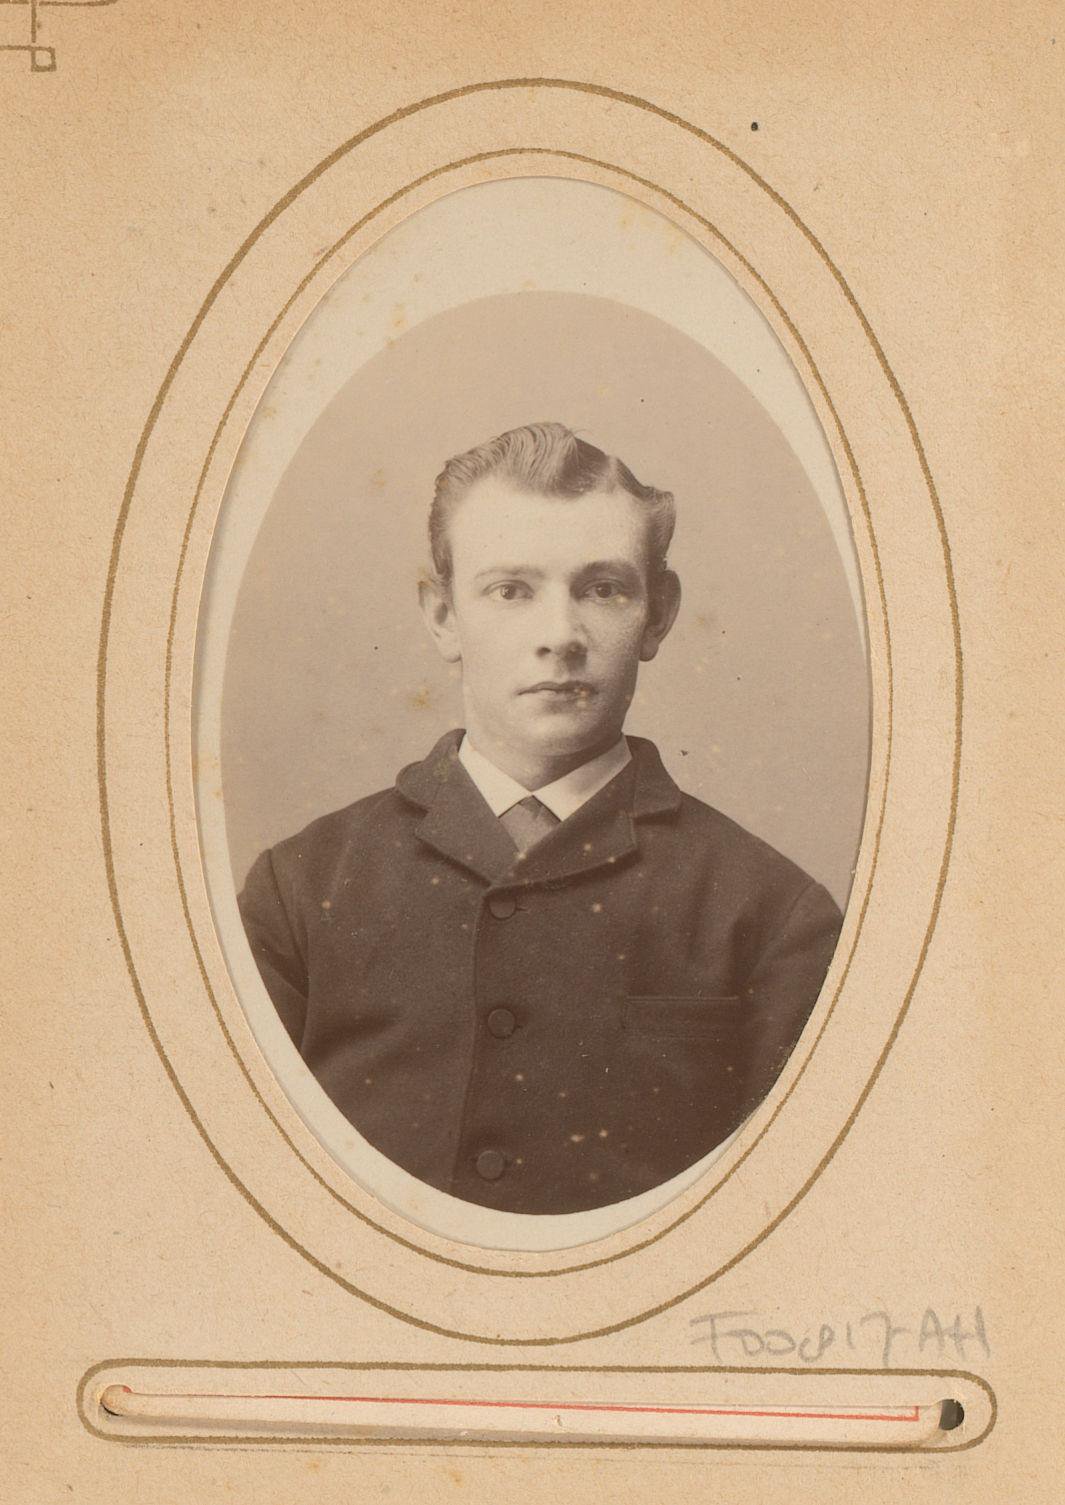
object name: album leaf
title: Portret van een jongeman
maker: Anonymous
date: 1860-1900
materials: cardboard, photographic support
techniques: albumen print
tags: youth, adolescent